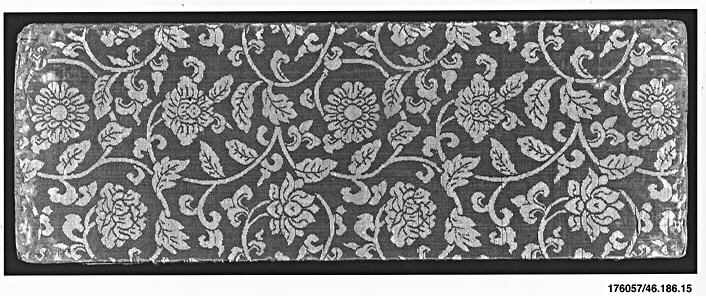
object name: sutra cover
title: Sutra Cover with Floral Scroll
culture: chinese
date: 1501-1600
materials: silk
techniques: patterning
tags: flowers,leaves